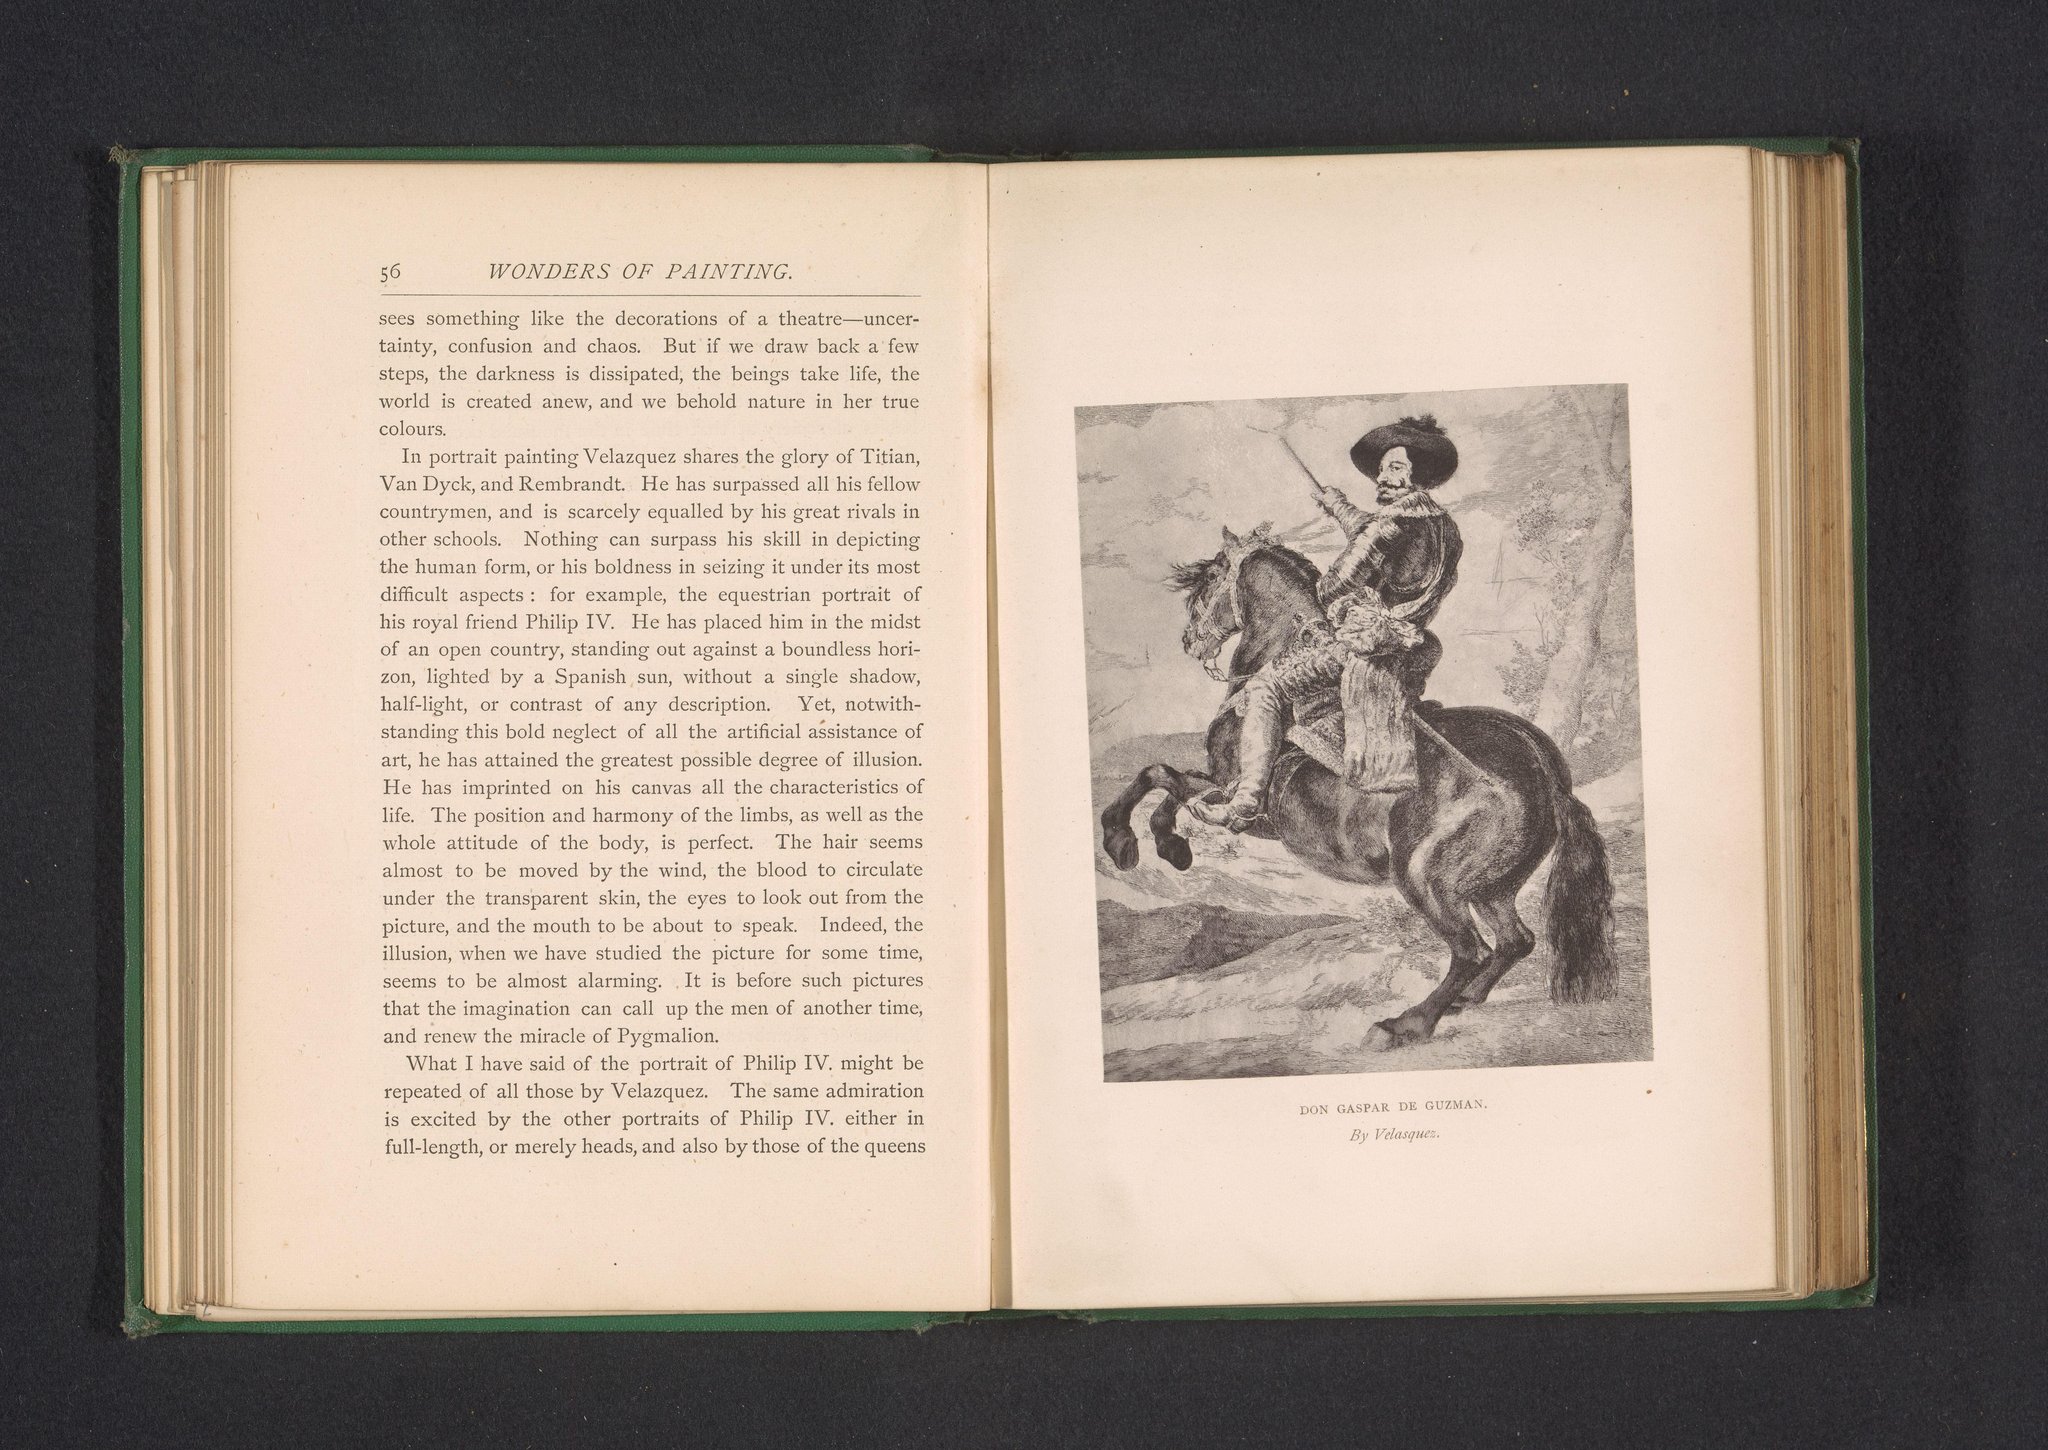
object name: photomechanical print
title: Don gaspar de Guzman. By Velasquez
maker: Anonymous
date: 1861-1871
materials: paper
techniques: woodburytype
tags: gaspar de haro y guzmán (markies van carpio en liche), equestrian state-portrait